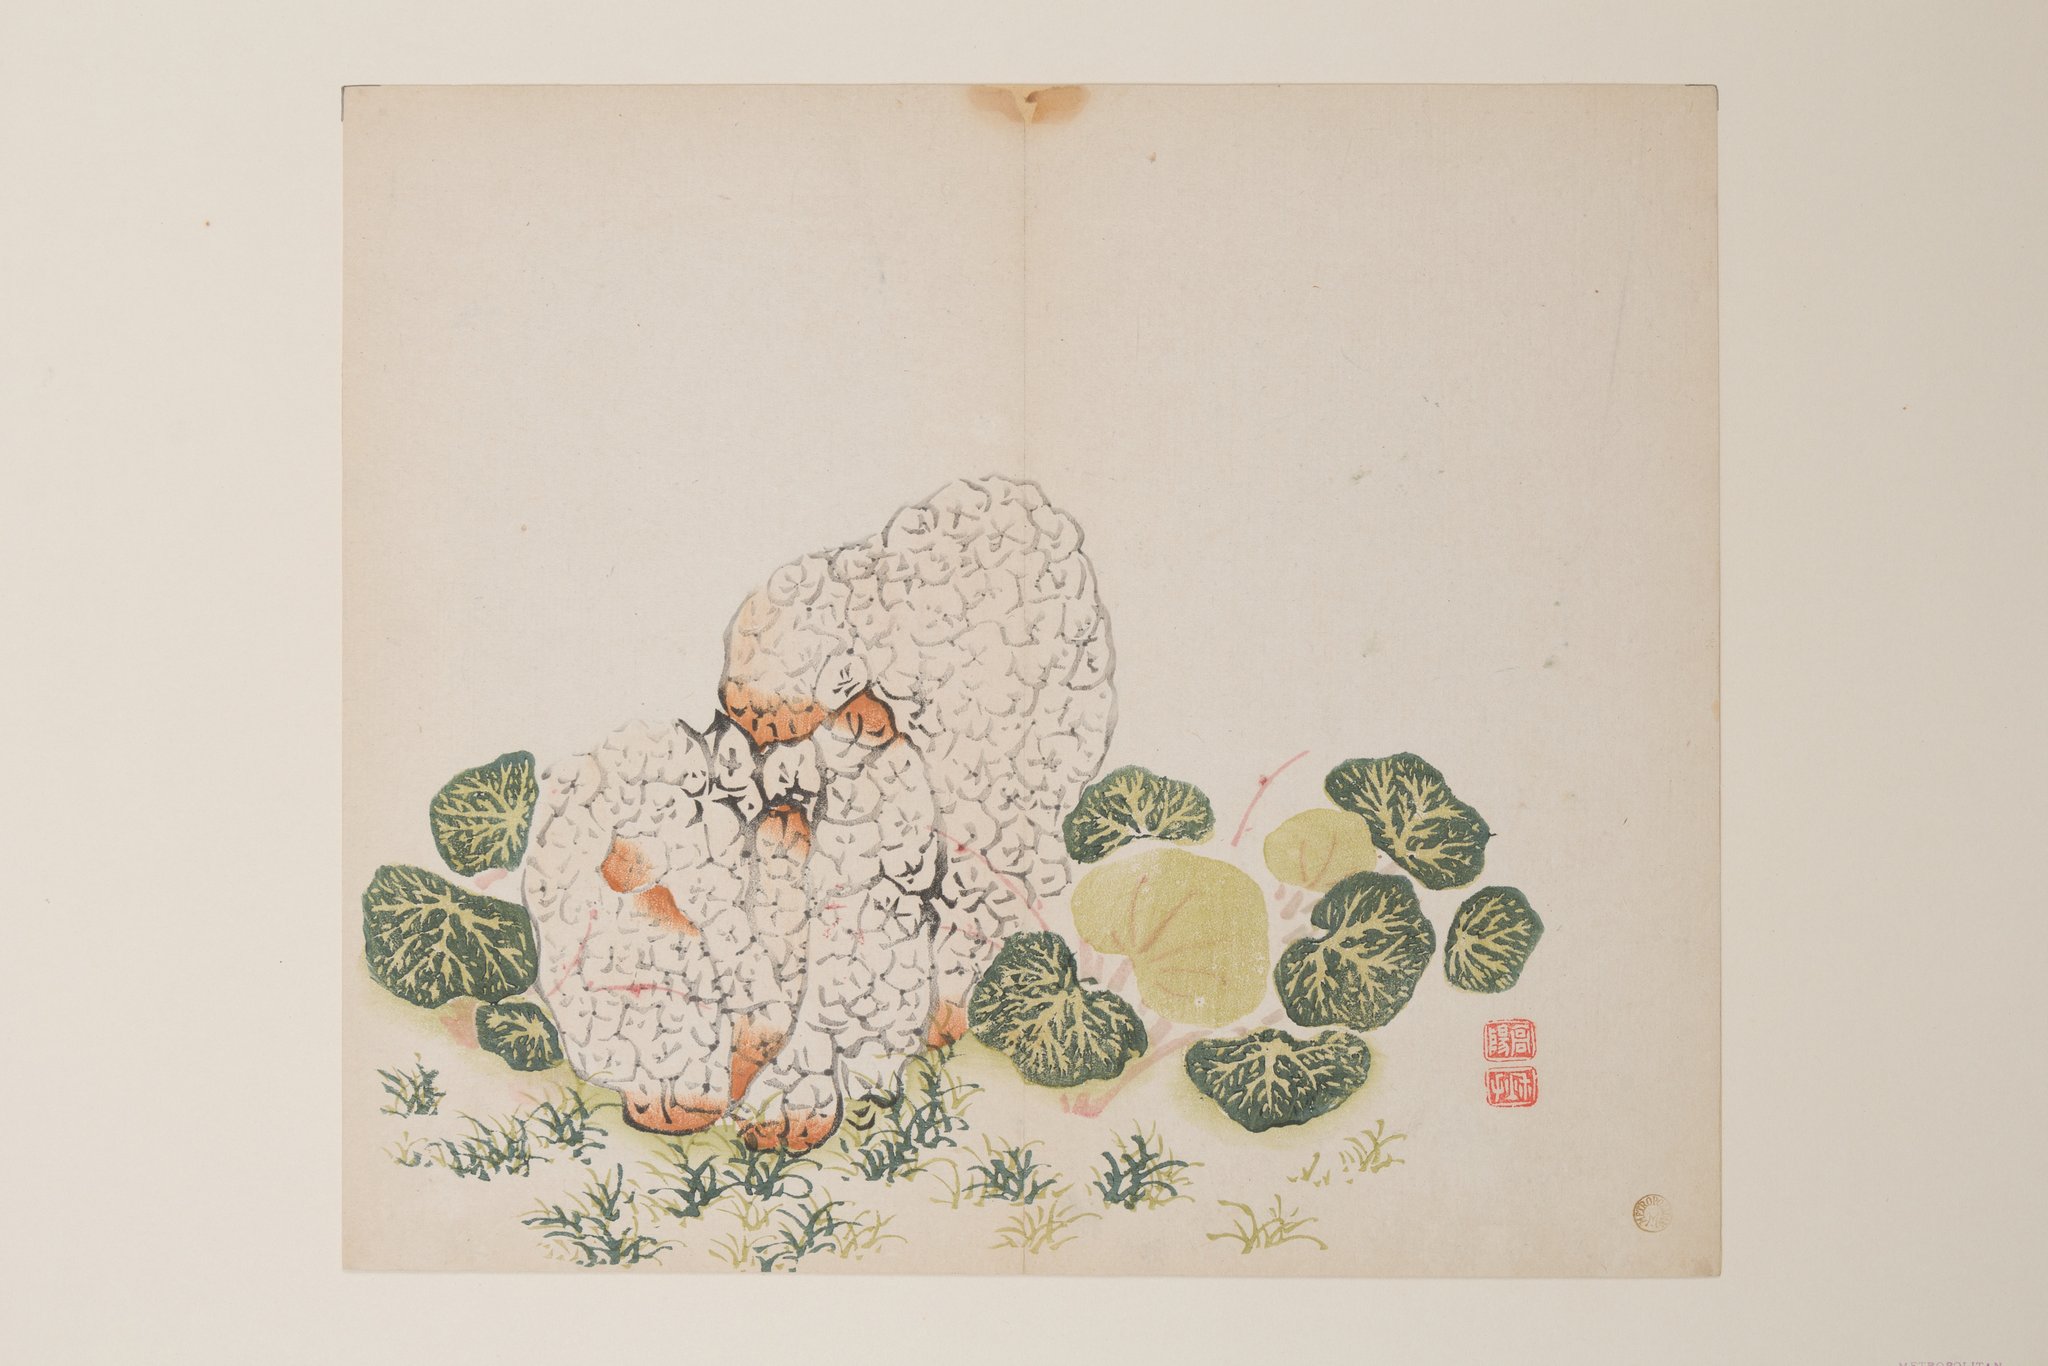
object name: print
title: Leaf from the Ten Bamboo Studio Manual of Painting and Calligraphy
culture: chinese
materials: ink, paper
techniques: printing